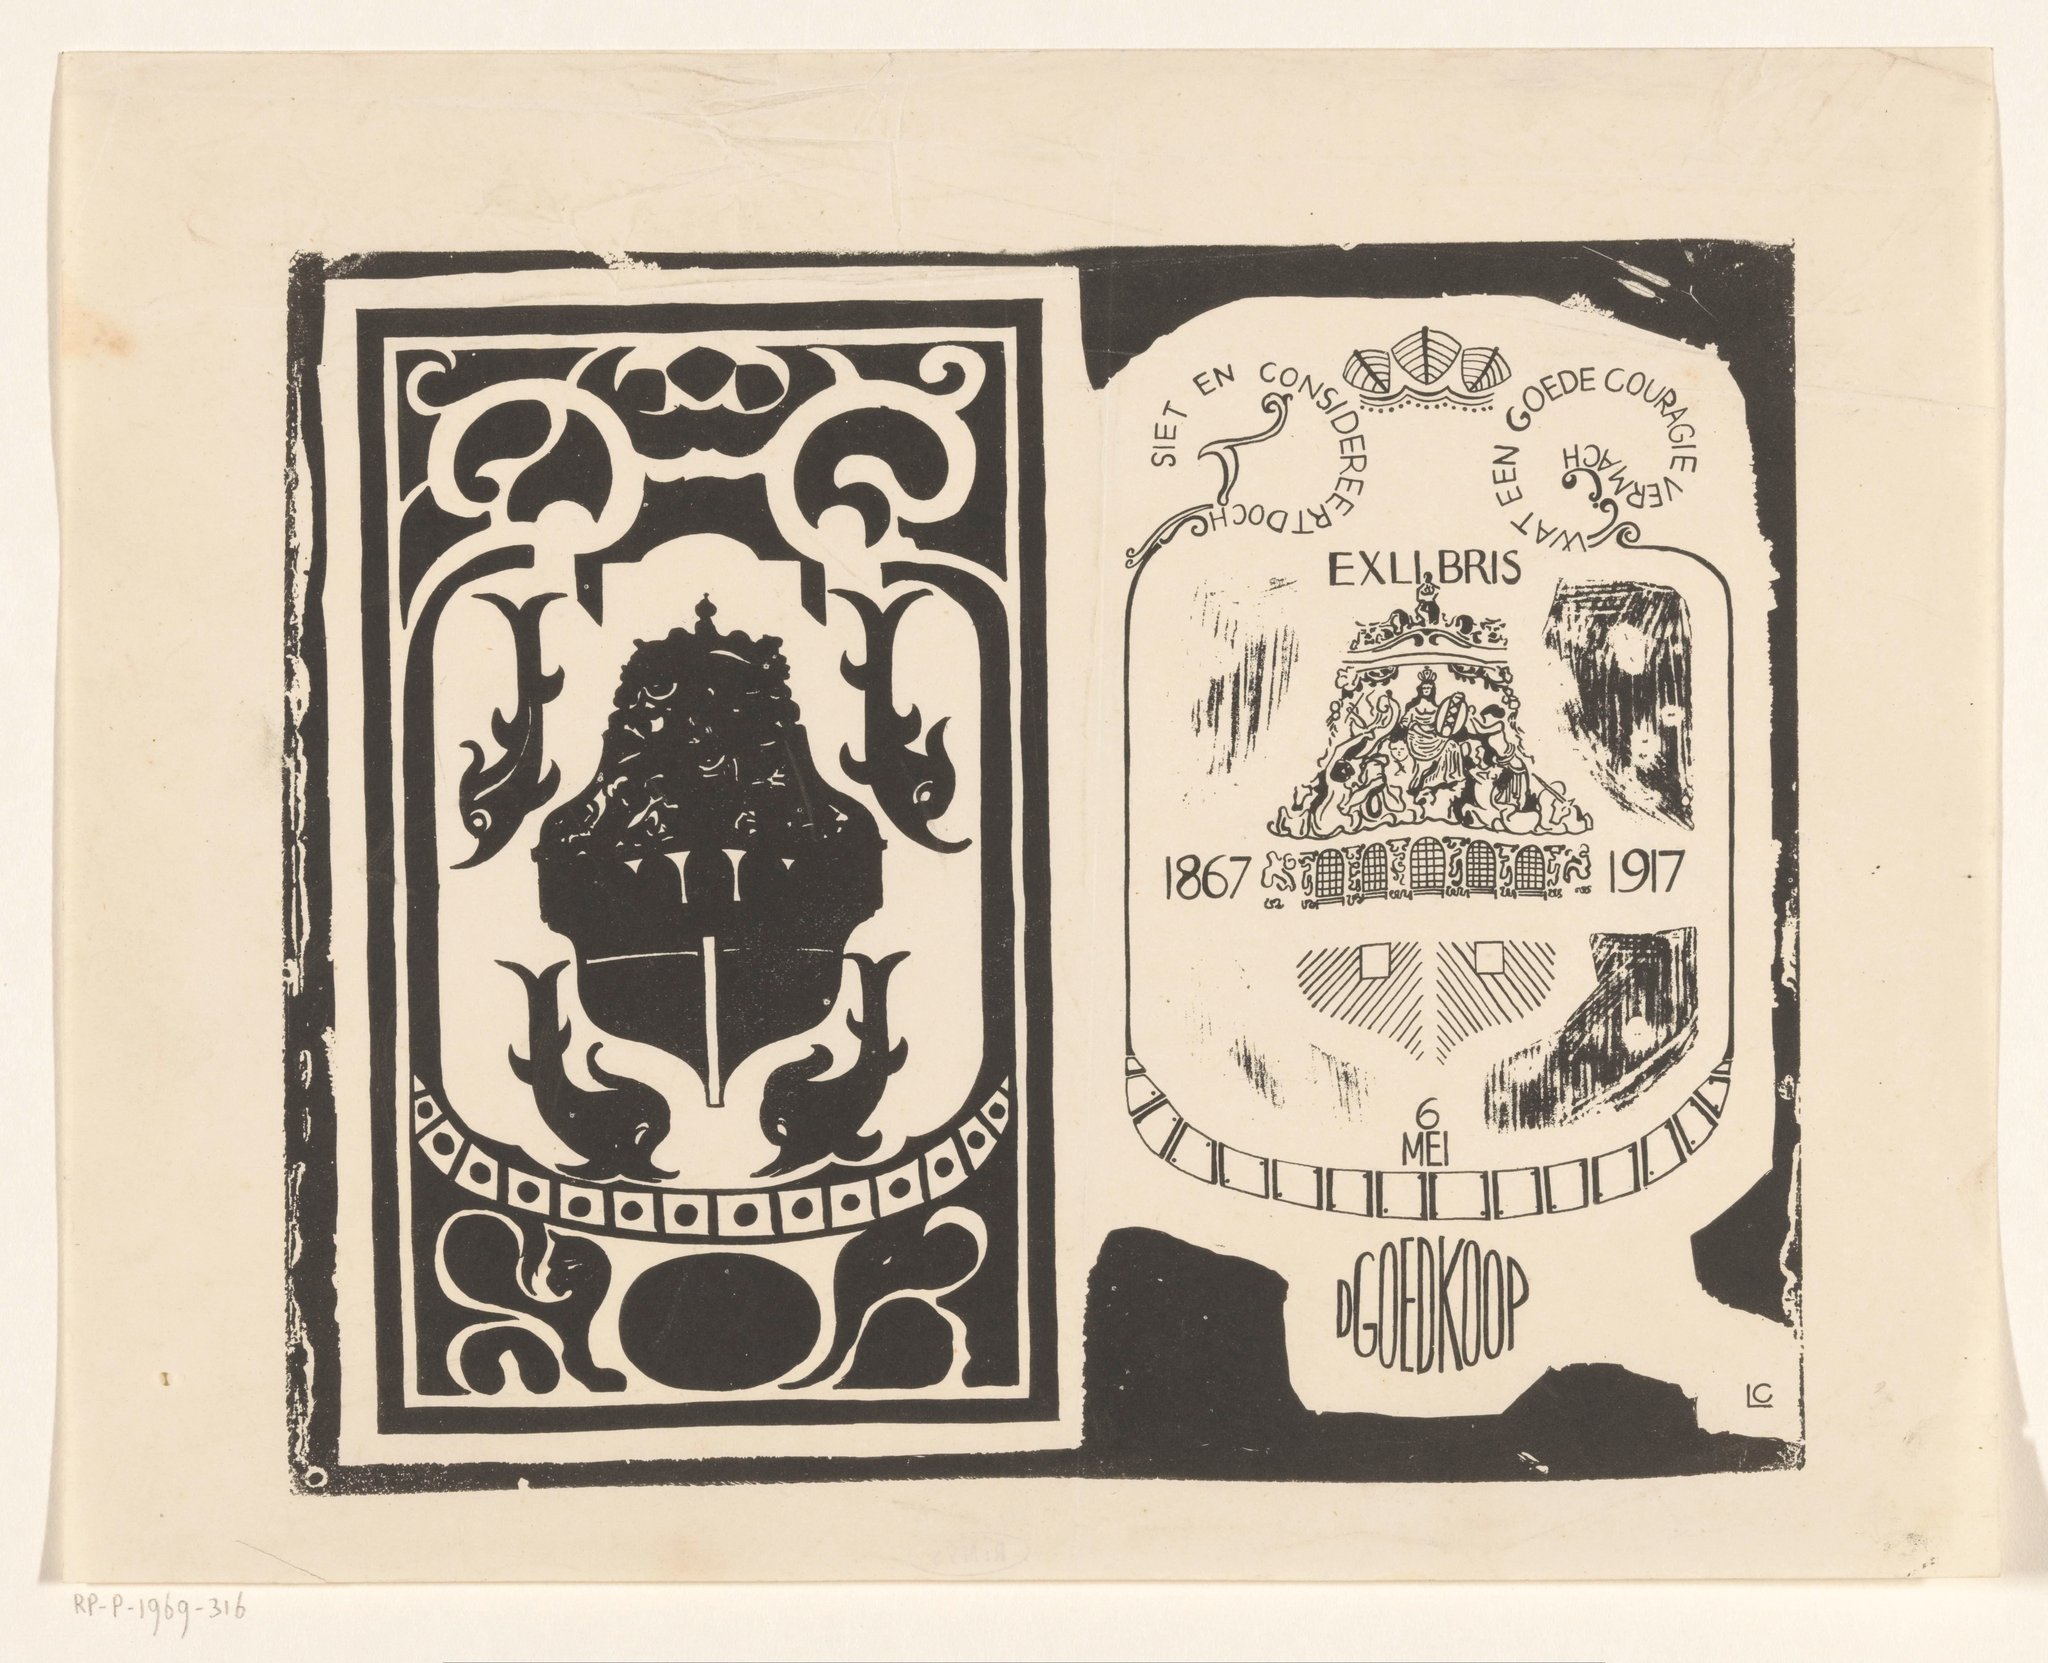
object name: print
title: Ex libris van D. Goedkoop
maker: carel adolph lion cachet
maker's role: draughtsman, print maker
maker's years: 1864-1945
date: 1917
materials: paper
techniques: lithograph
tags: dolphin ~ ornament, parts of ship's exterior: bow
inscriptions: collector's mark: Lugt 2228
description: Links een kader met vier dolfijnen. Rechts de contouren van een schip.